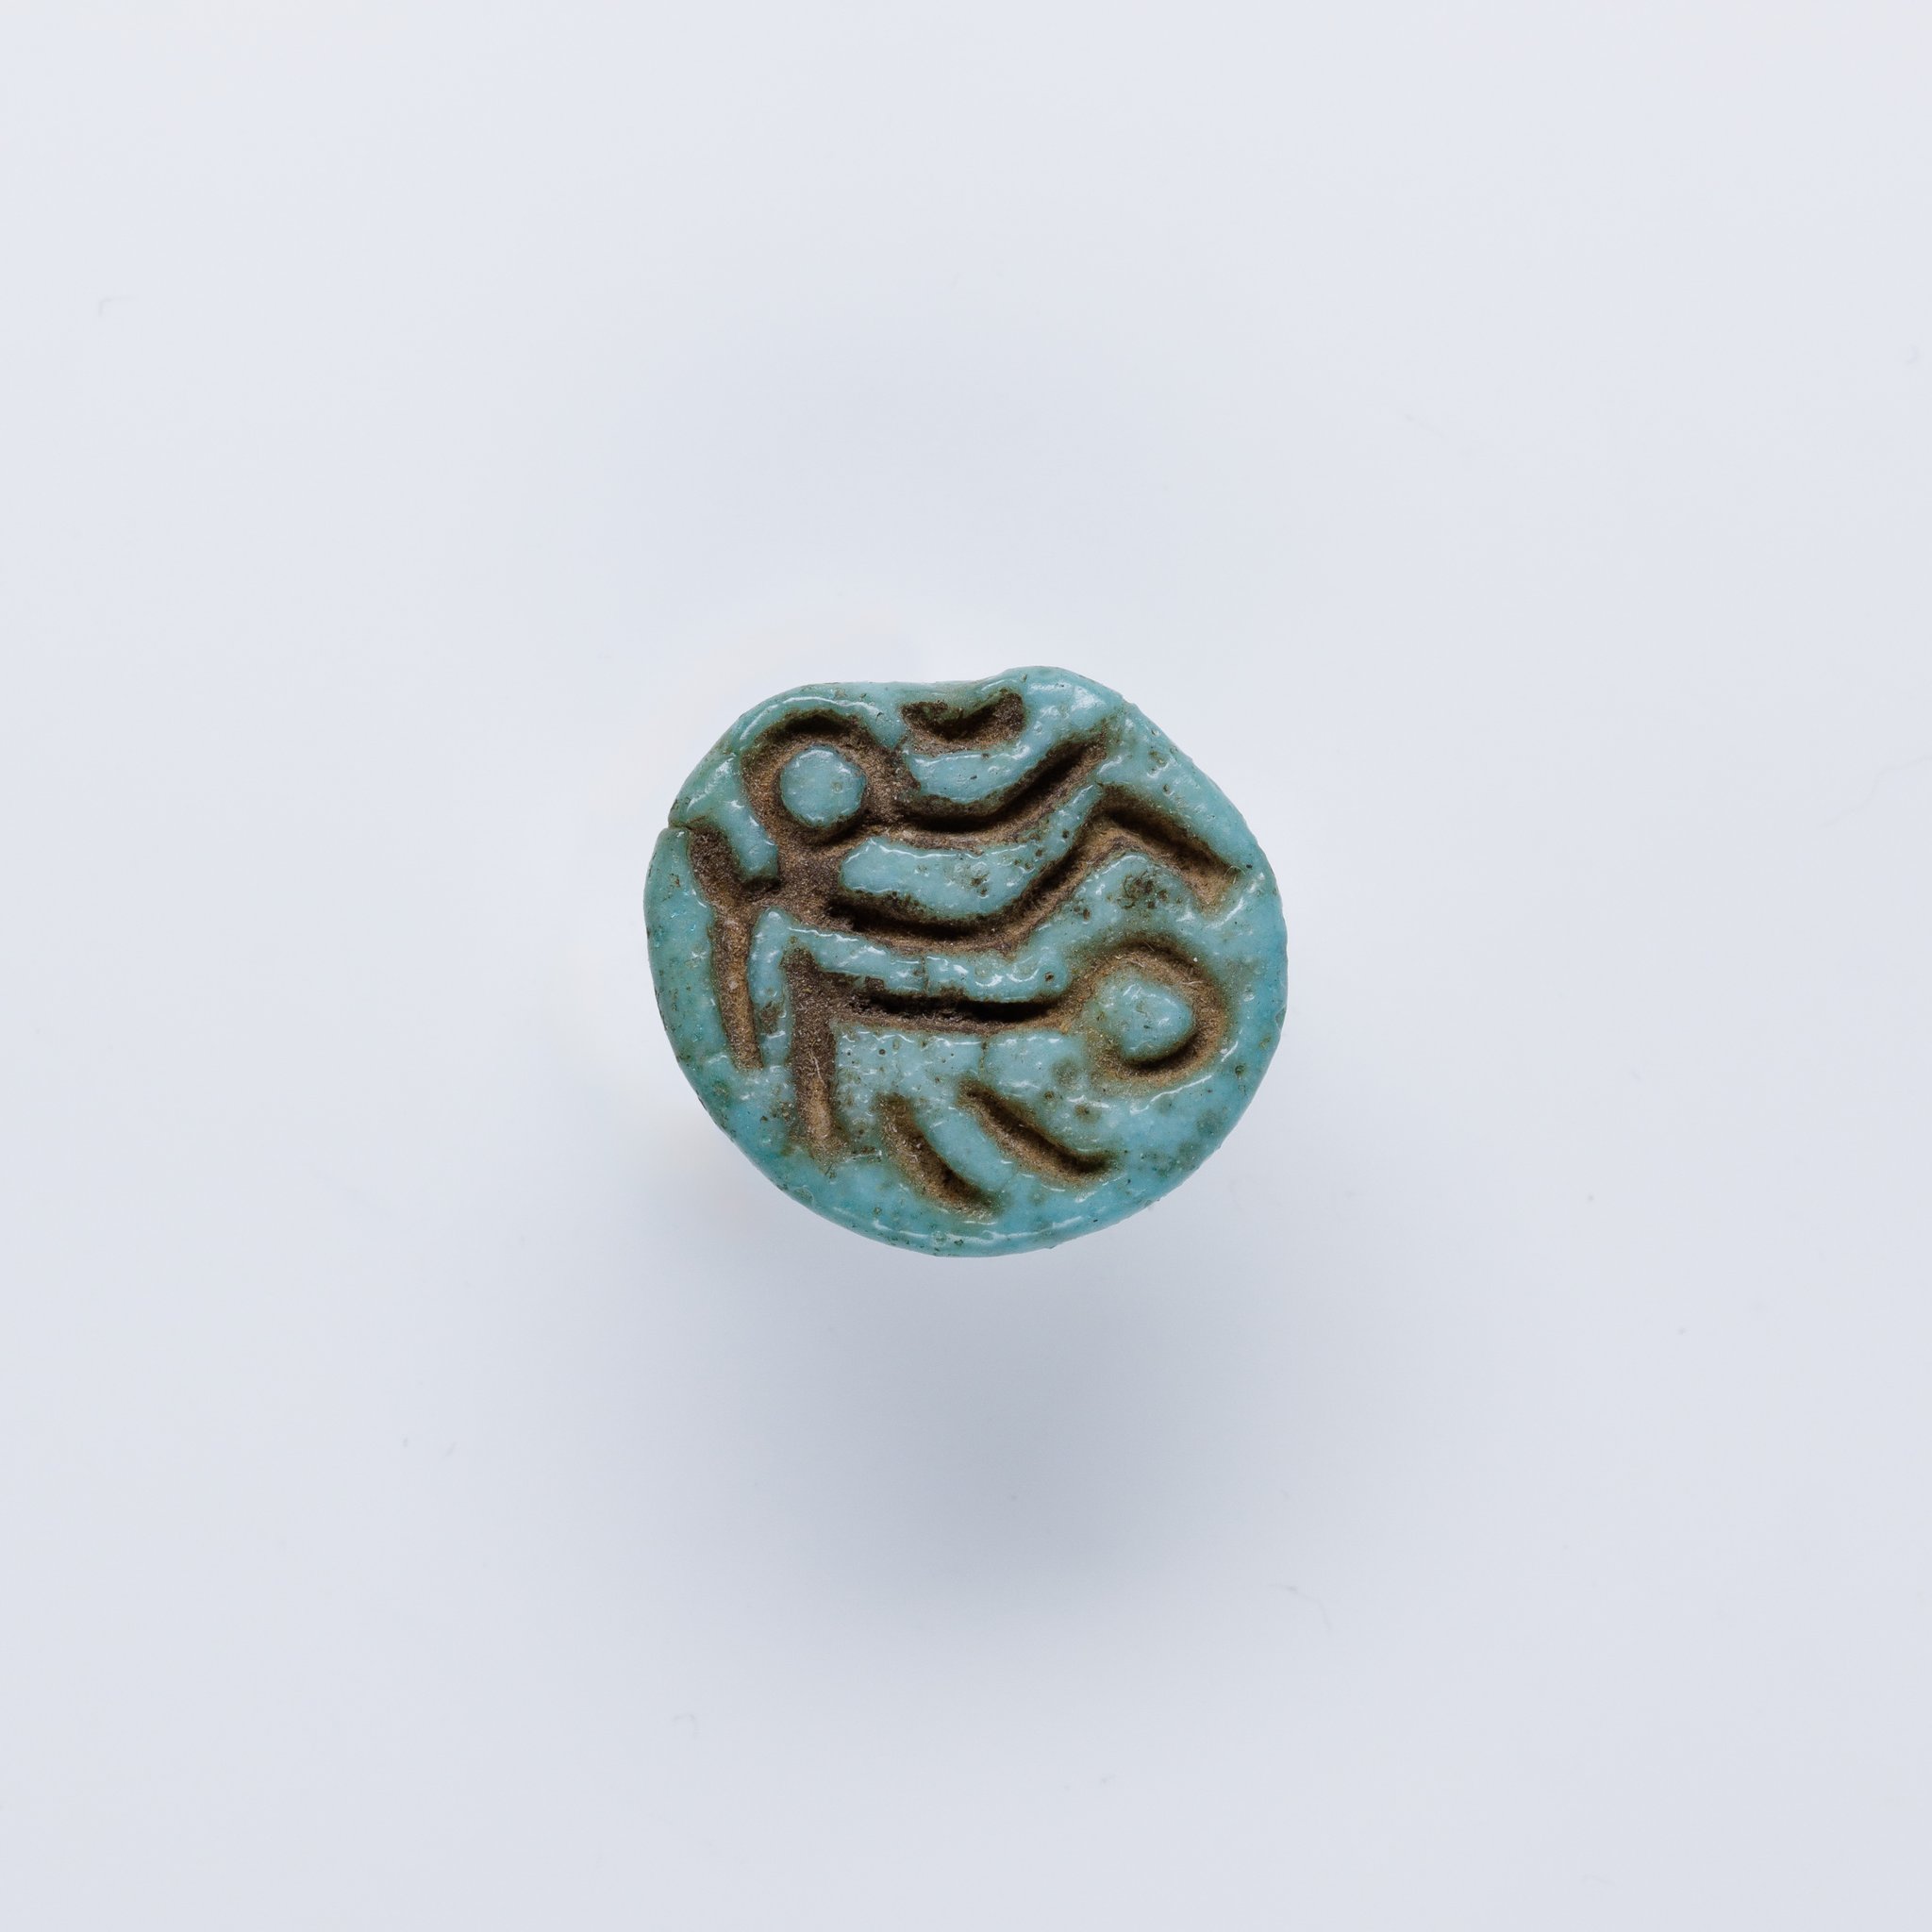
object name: design amulet, child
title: Design Amulet with Loop on the Back, Device of Two Children shown in Opposite Vertical Orientations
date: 2100-1950 BCE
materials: faience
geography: egypt